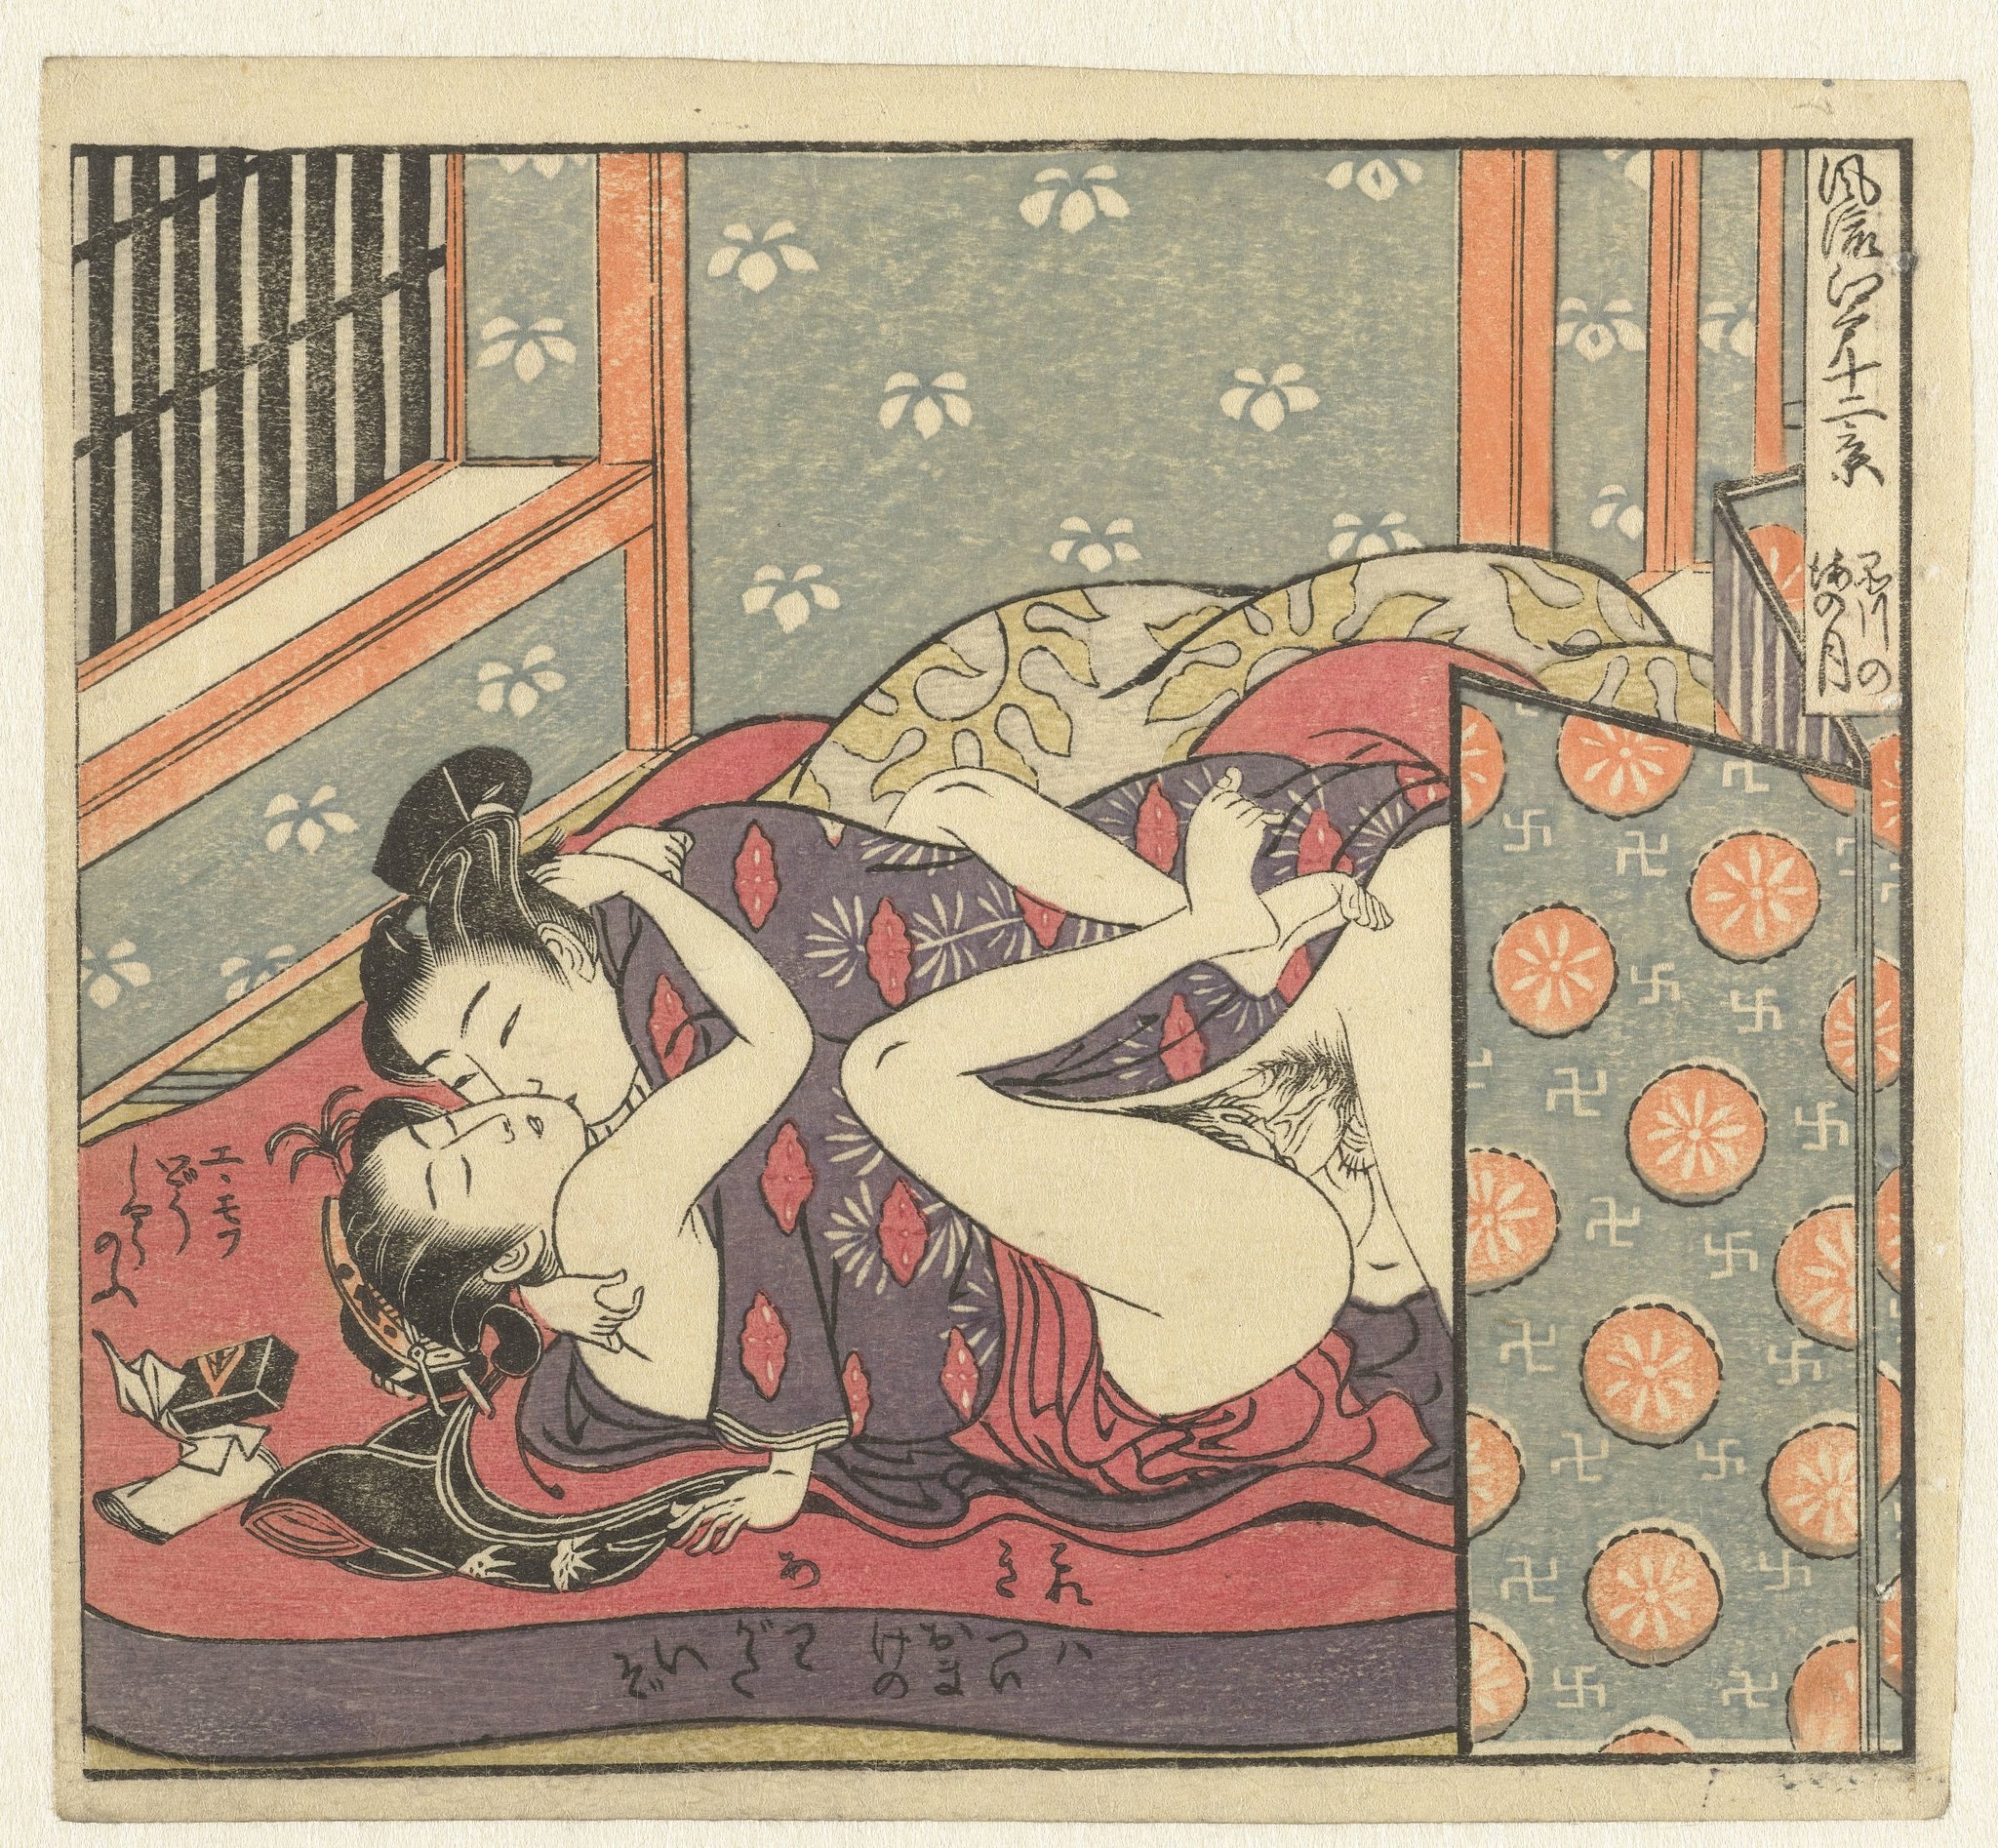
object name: print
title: Liefdespaar achter kamerscherm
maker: isoda kôryûsai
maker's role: print maker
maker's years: 1735-1790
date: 1770-1775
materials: paper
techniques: woodcut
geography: japan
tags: coitus, cohabiting, sexual intercourse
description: Copulerend paar, liggend onder raam, op een futon; rechtsvoor een kamerscherm.